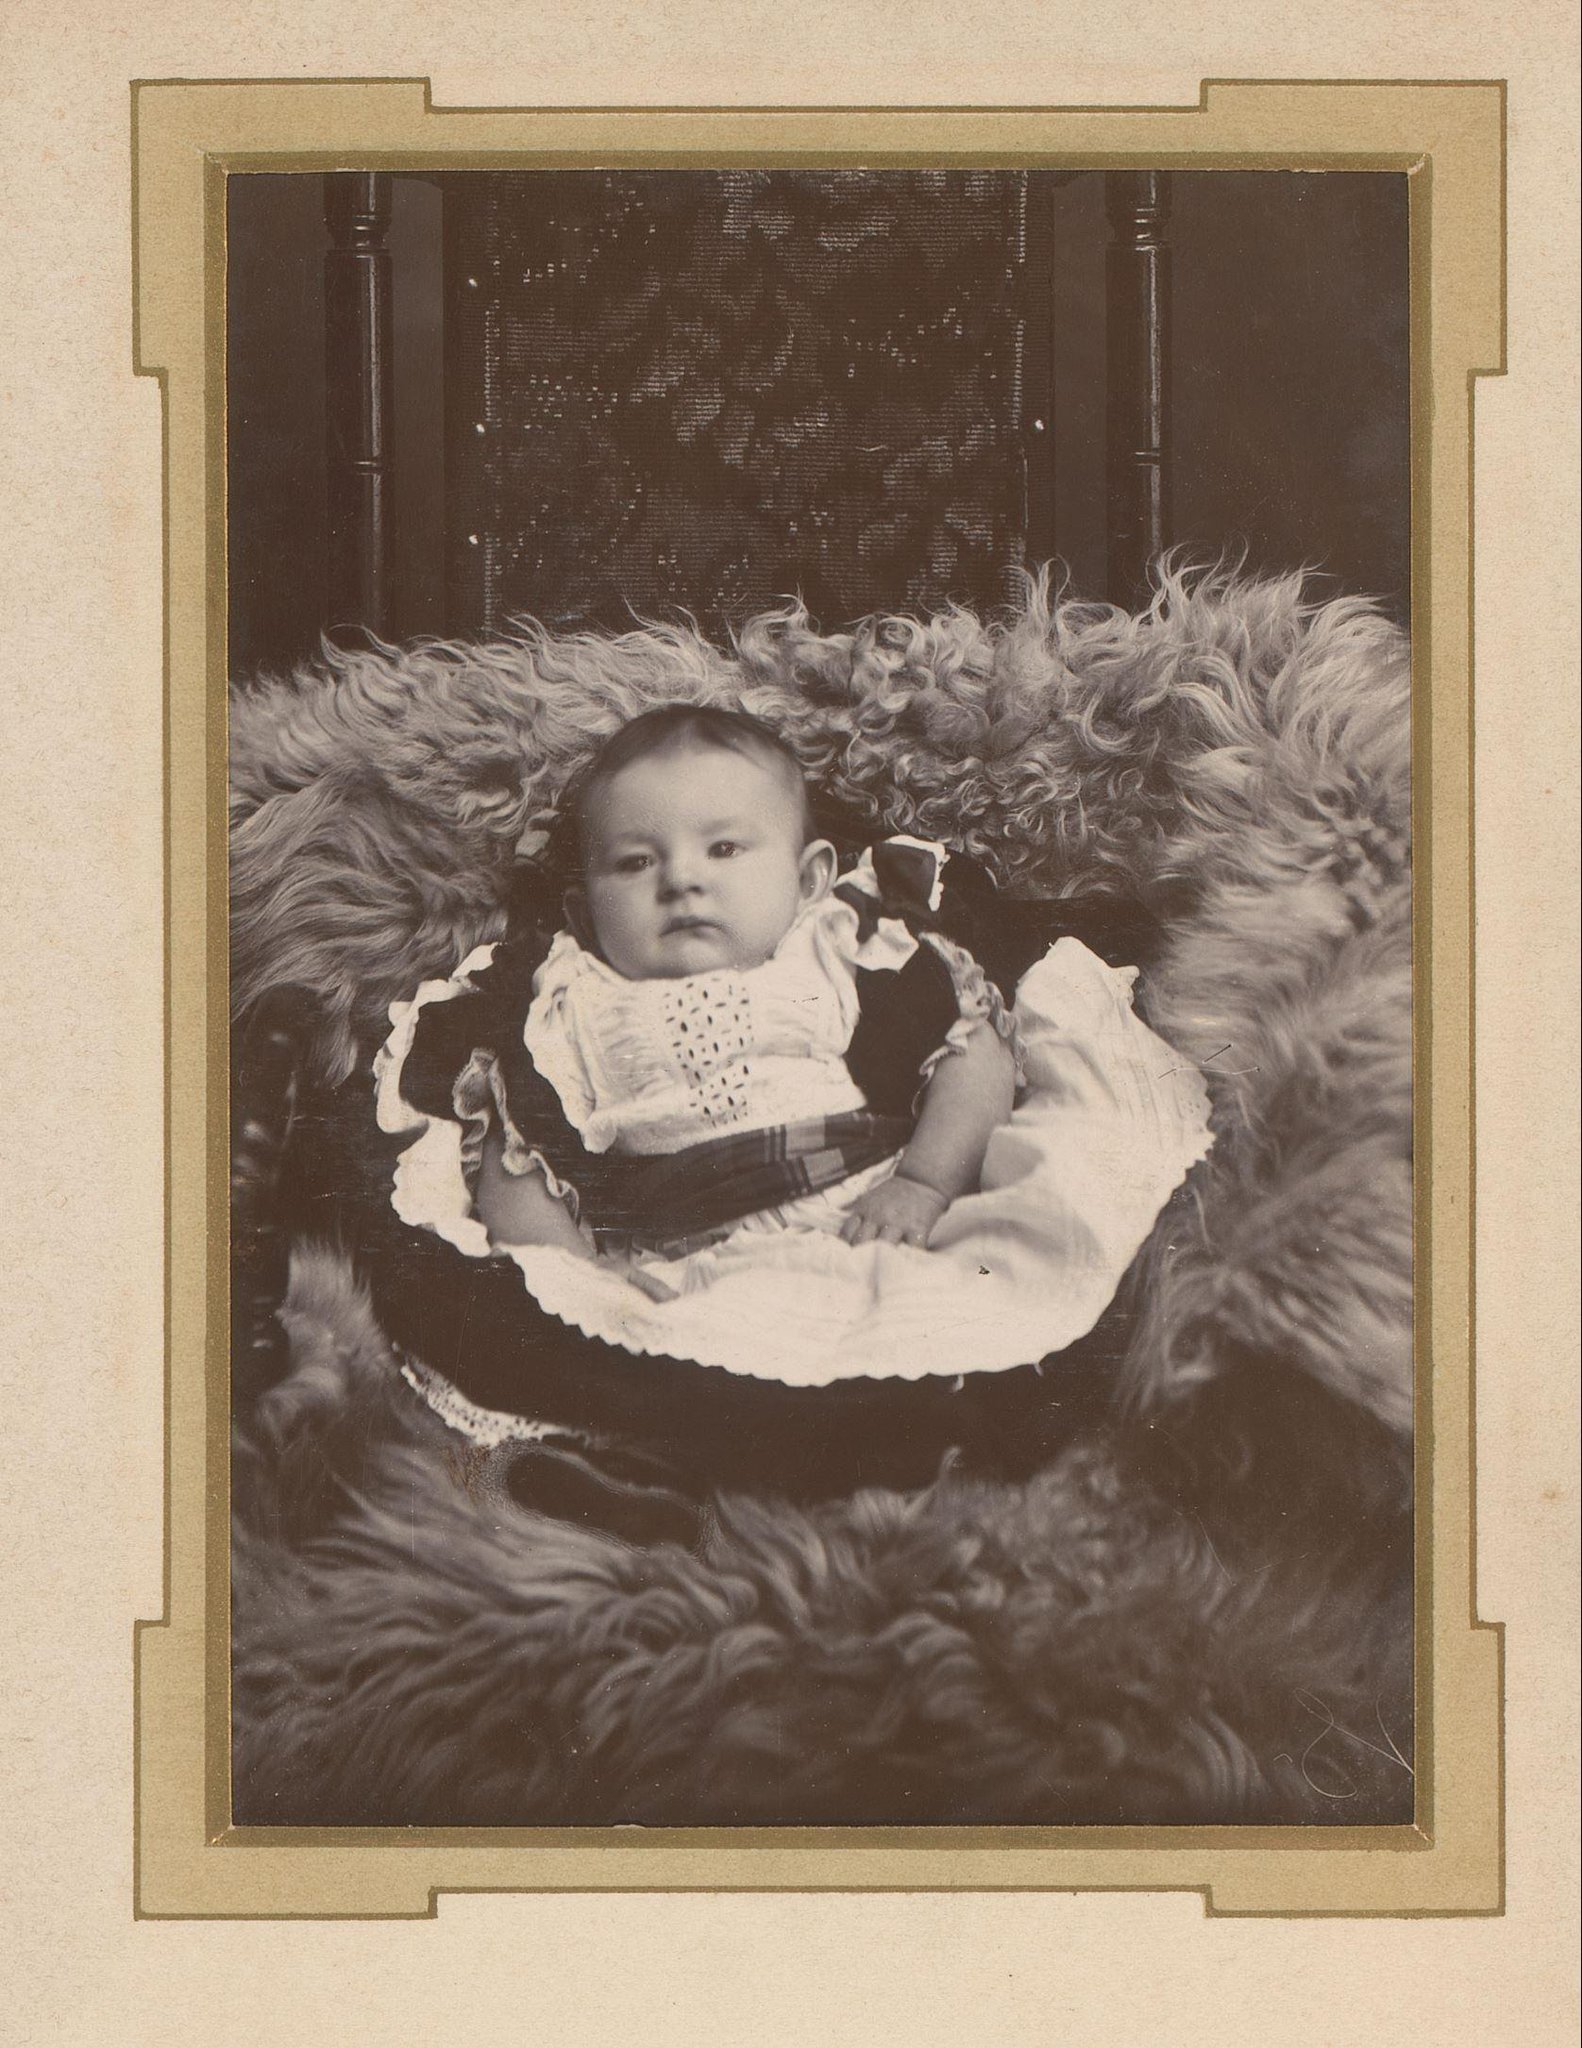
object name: photograph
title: Portret van een baby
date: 1880-1920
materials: cardboard, photographic support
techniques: collodion silver print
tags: historical persons, infant, baby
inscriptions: inscription: ‘Northern/ Art Photo/ CO. Ltd./ Bridge St./ Morpeth/ also at/ Turnbull's Buildings - Market-Place/ Blyth/ (...)’